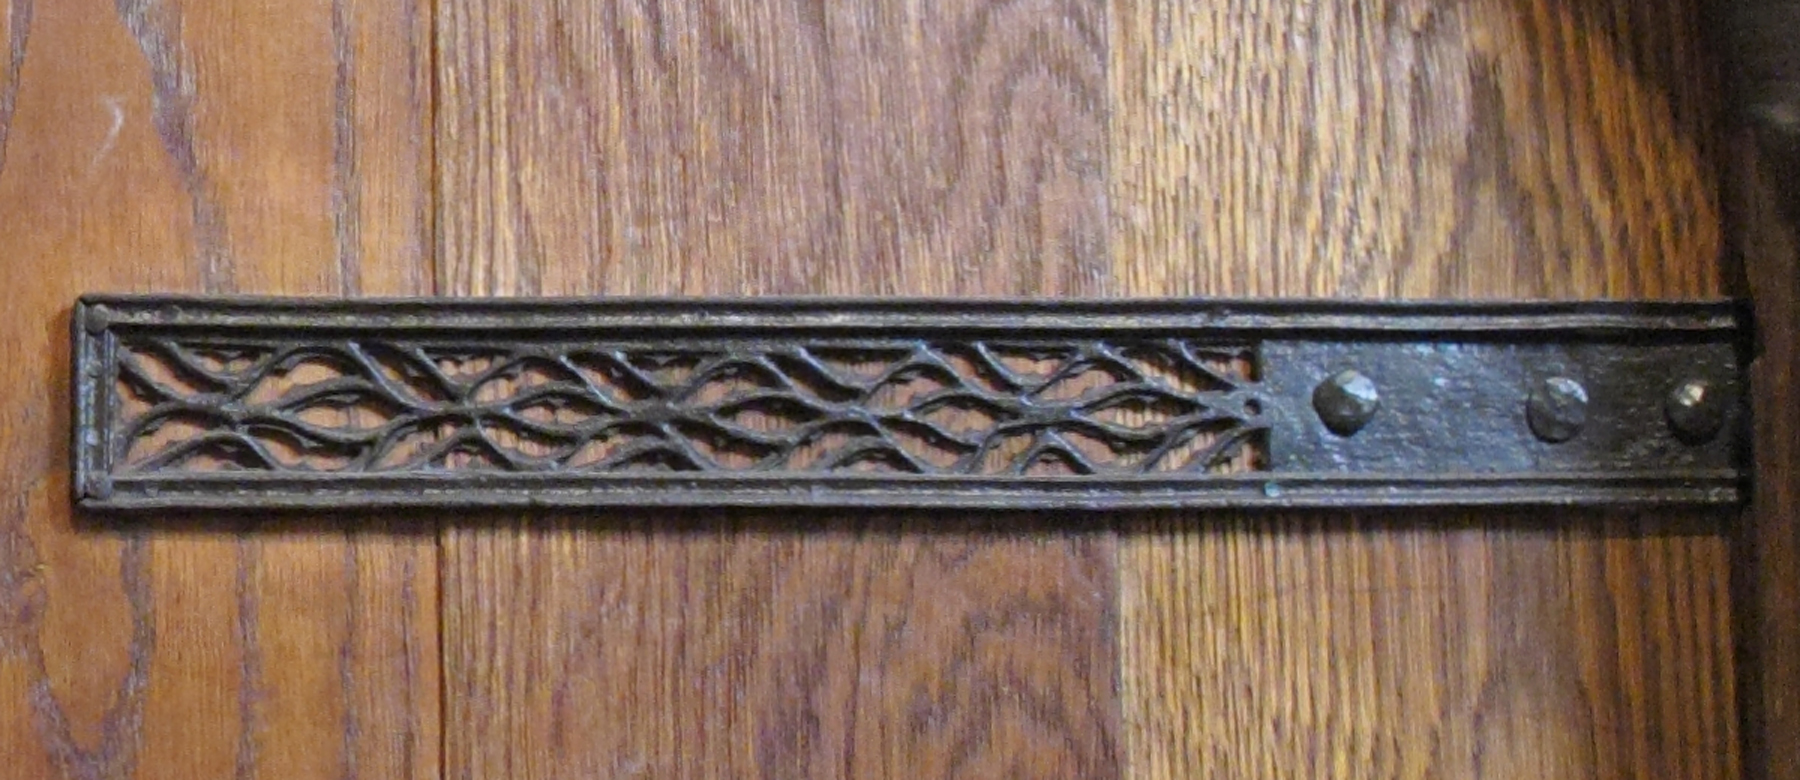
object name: hinge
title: Strap Hinge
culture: european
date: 1401-1600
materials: iron